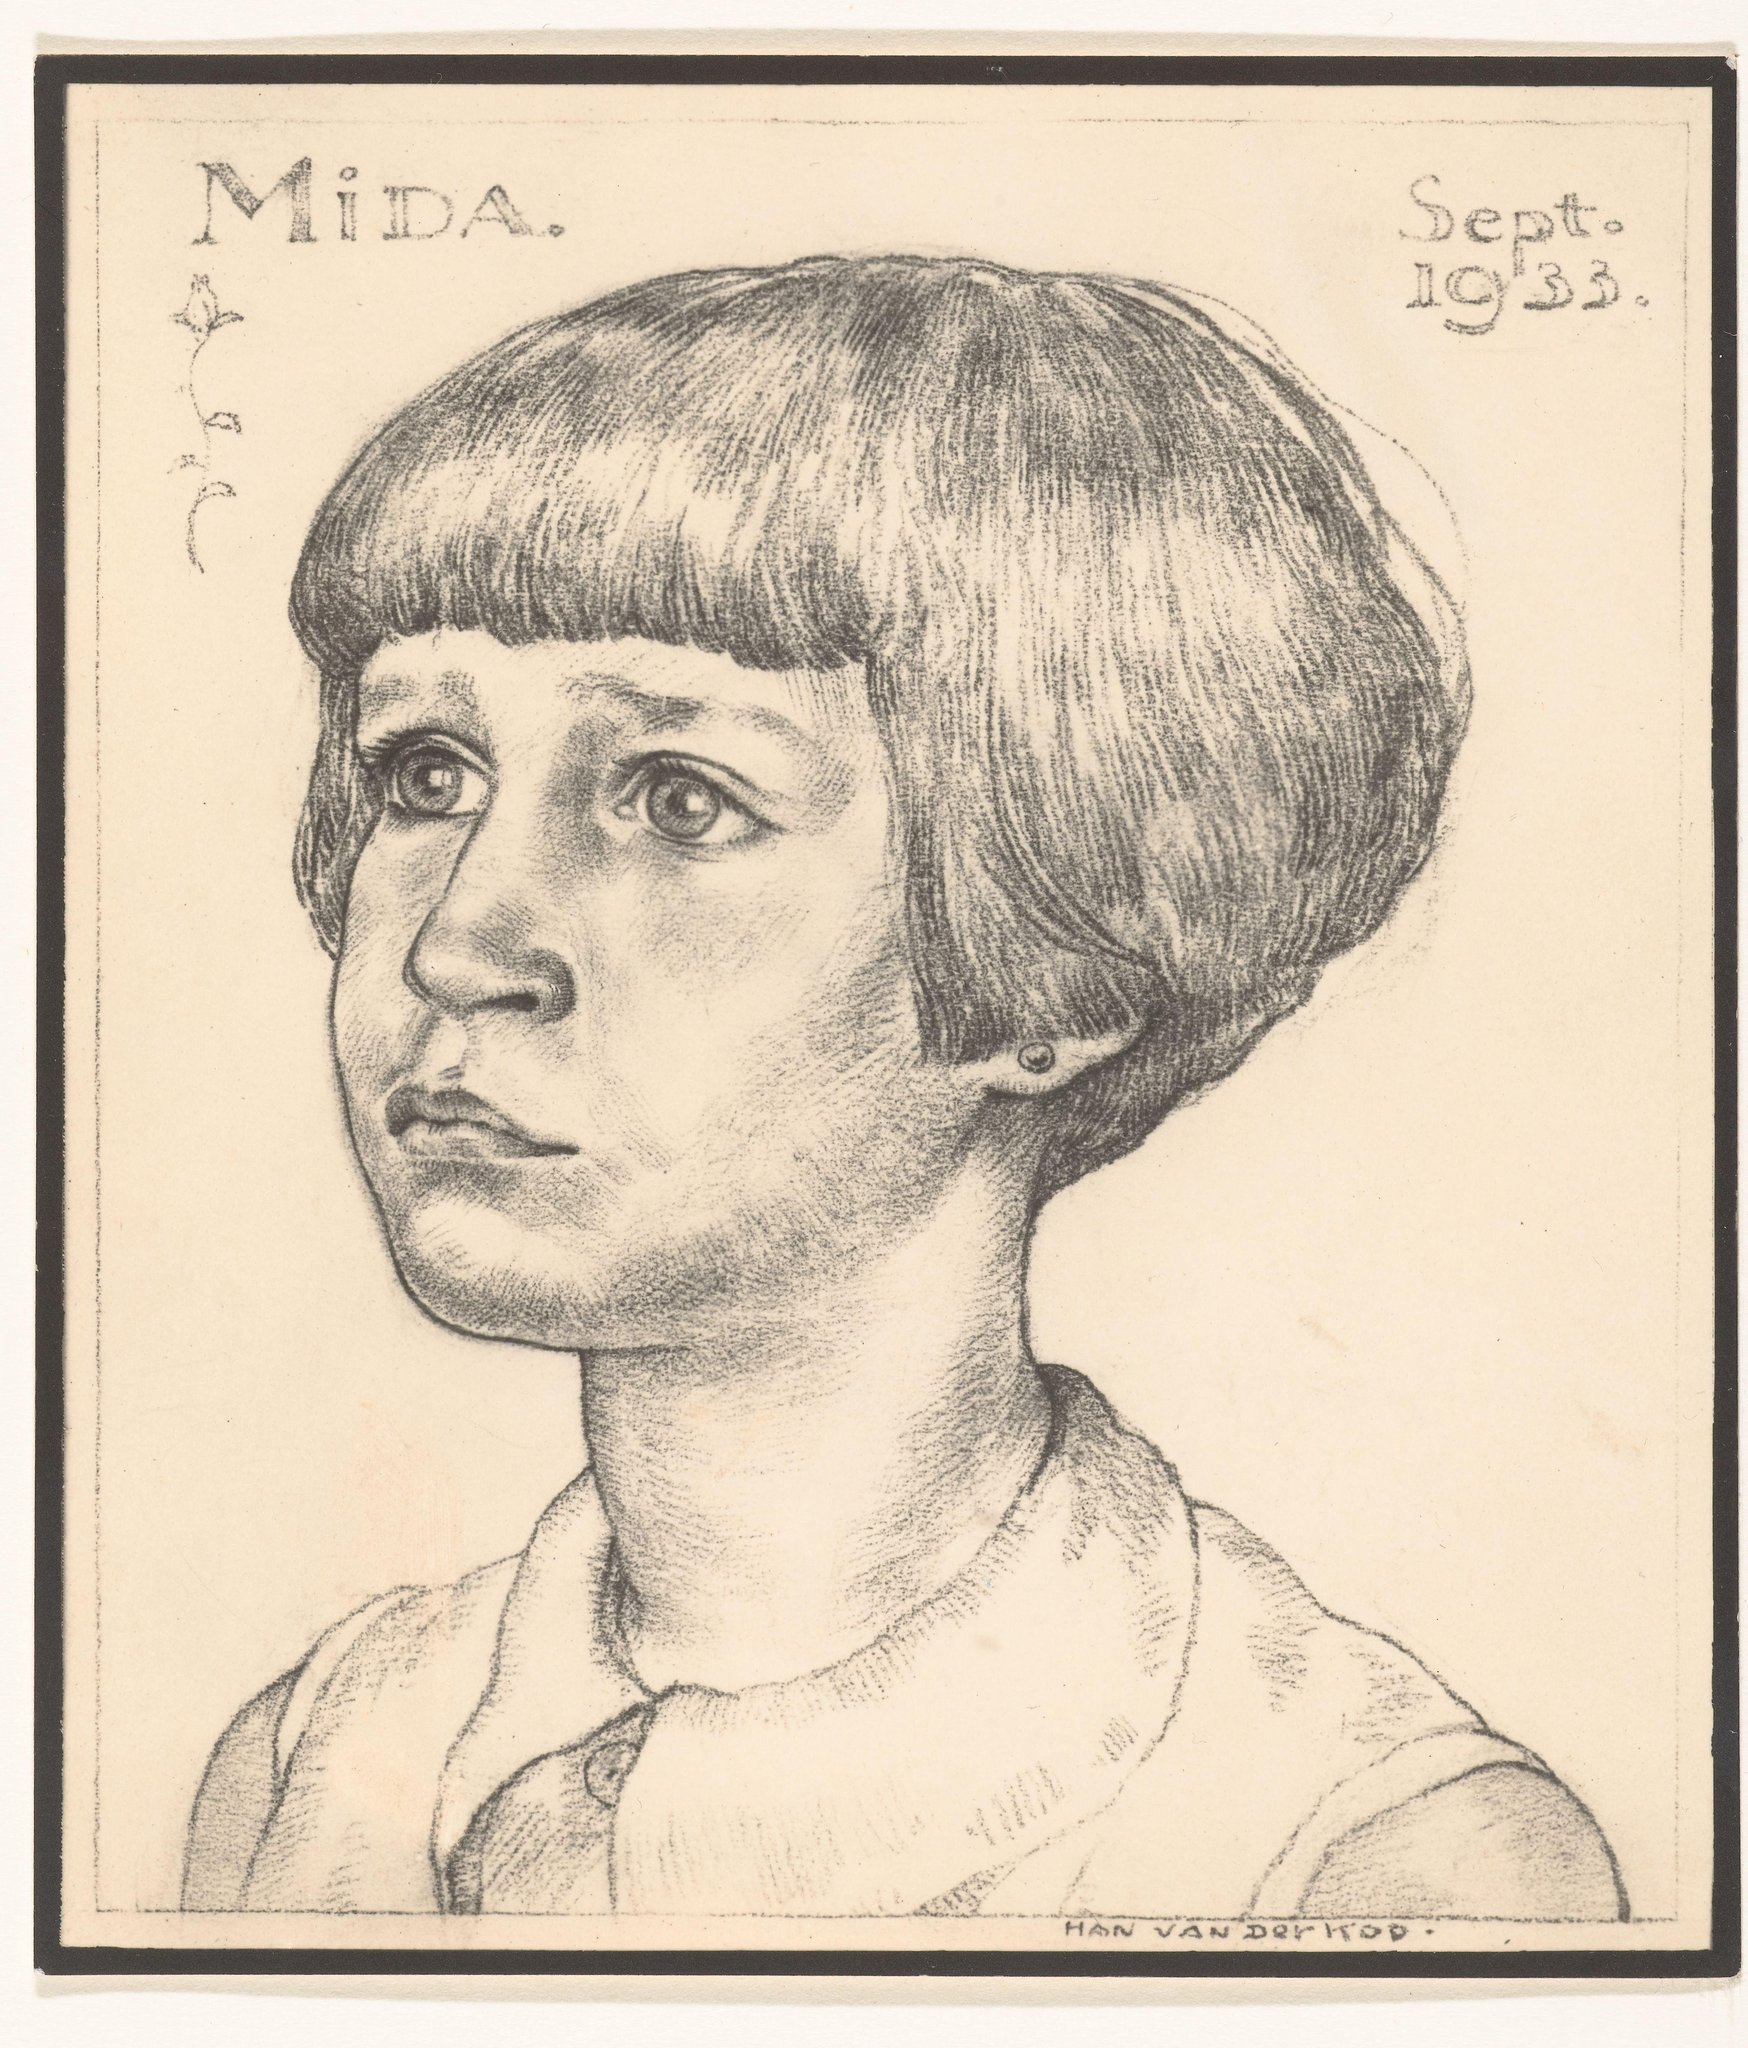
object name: photograph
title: Mida sept 1933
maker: adriaan bijl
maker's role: fotograaf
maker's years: 1874-1967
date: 1933-1960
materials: paper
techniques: gelatin silver print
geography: amsterdam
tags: drawing, historical persons - bb - woman, girl (child between toddler and youth), netherlands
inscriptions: annotation: ‘Mida sept 1933/ Han van de Kop’, annotation: ‘Reproductie van nagelaten werk van Han van der Kop’